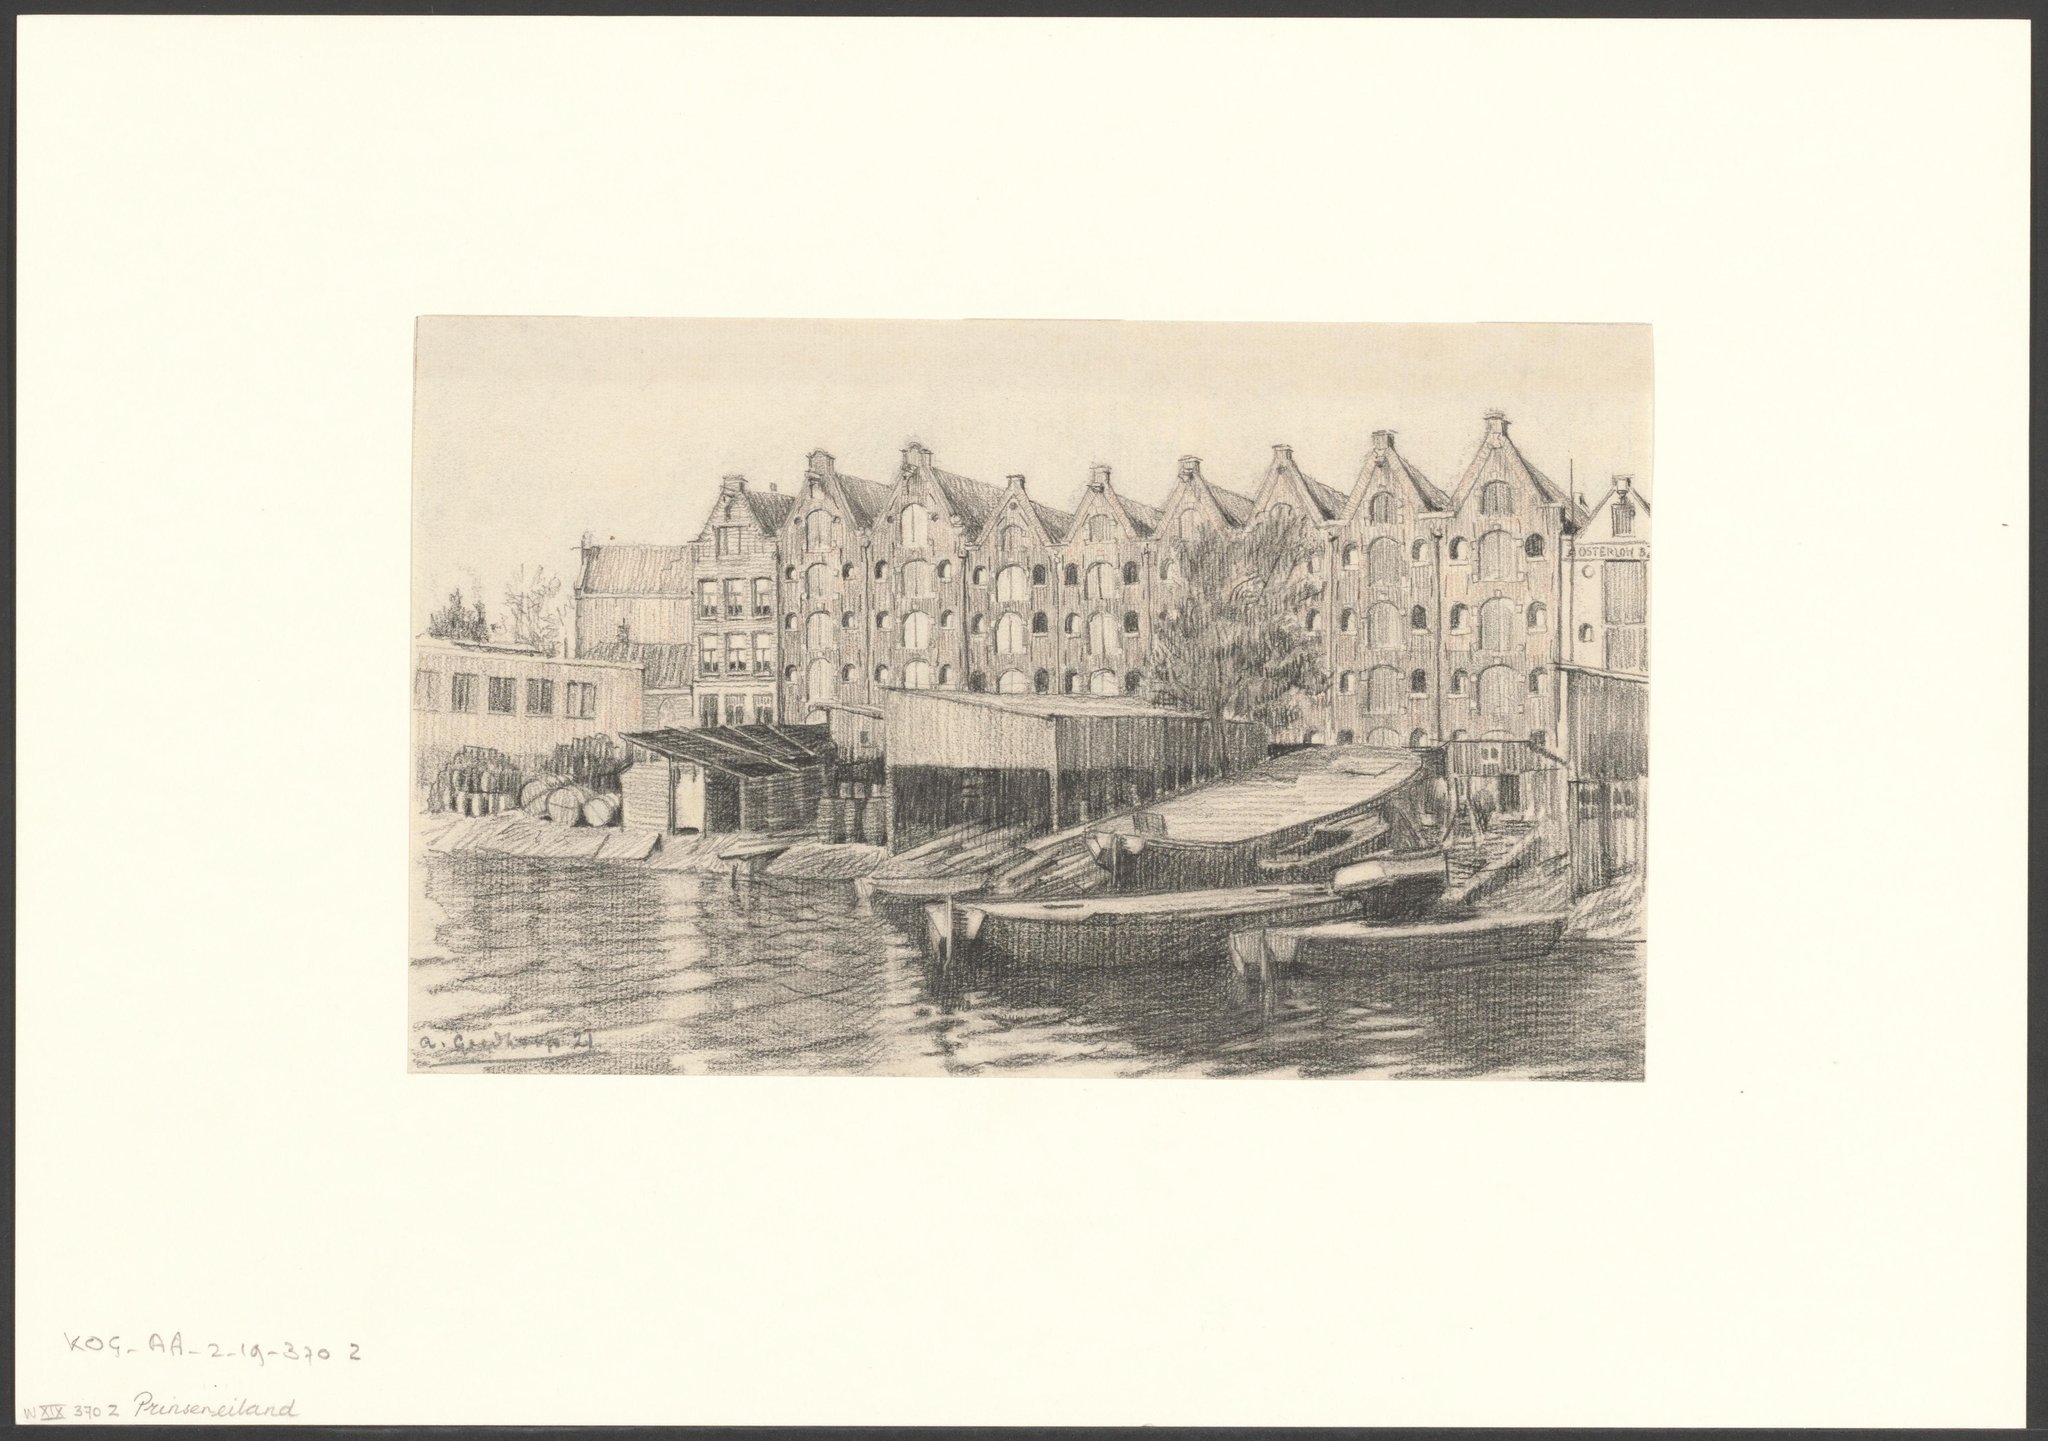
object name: drawing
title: Gezicht op de Eilandsgracht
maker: goedkoop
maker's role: draughtsman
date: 1921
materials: chalk, paper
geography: amsterdam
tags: city-view in general; 'veduta', canal, façade (of house or building)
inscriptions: signature and date: ‘a. goedkoop '21’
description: Tekening binnen de Atlas Van Eck ingedeeld op wijknummer 19.